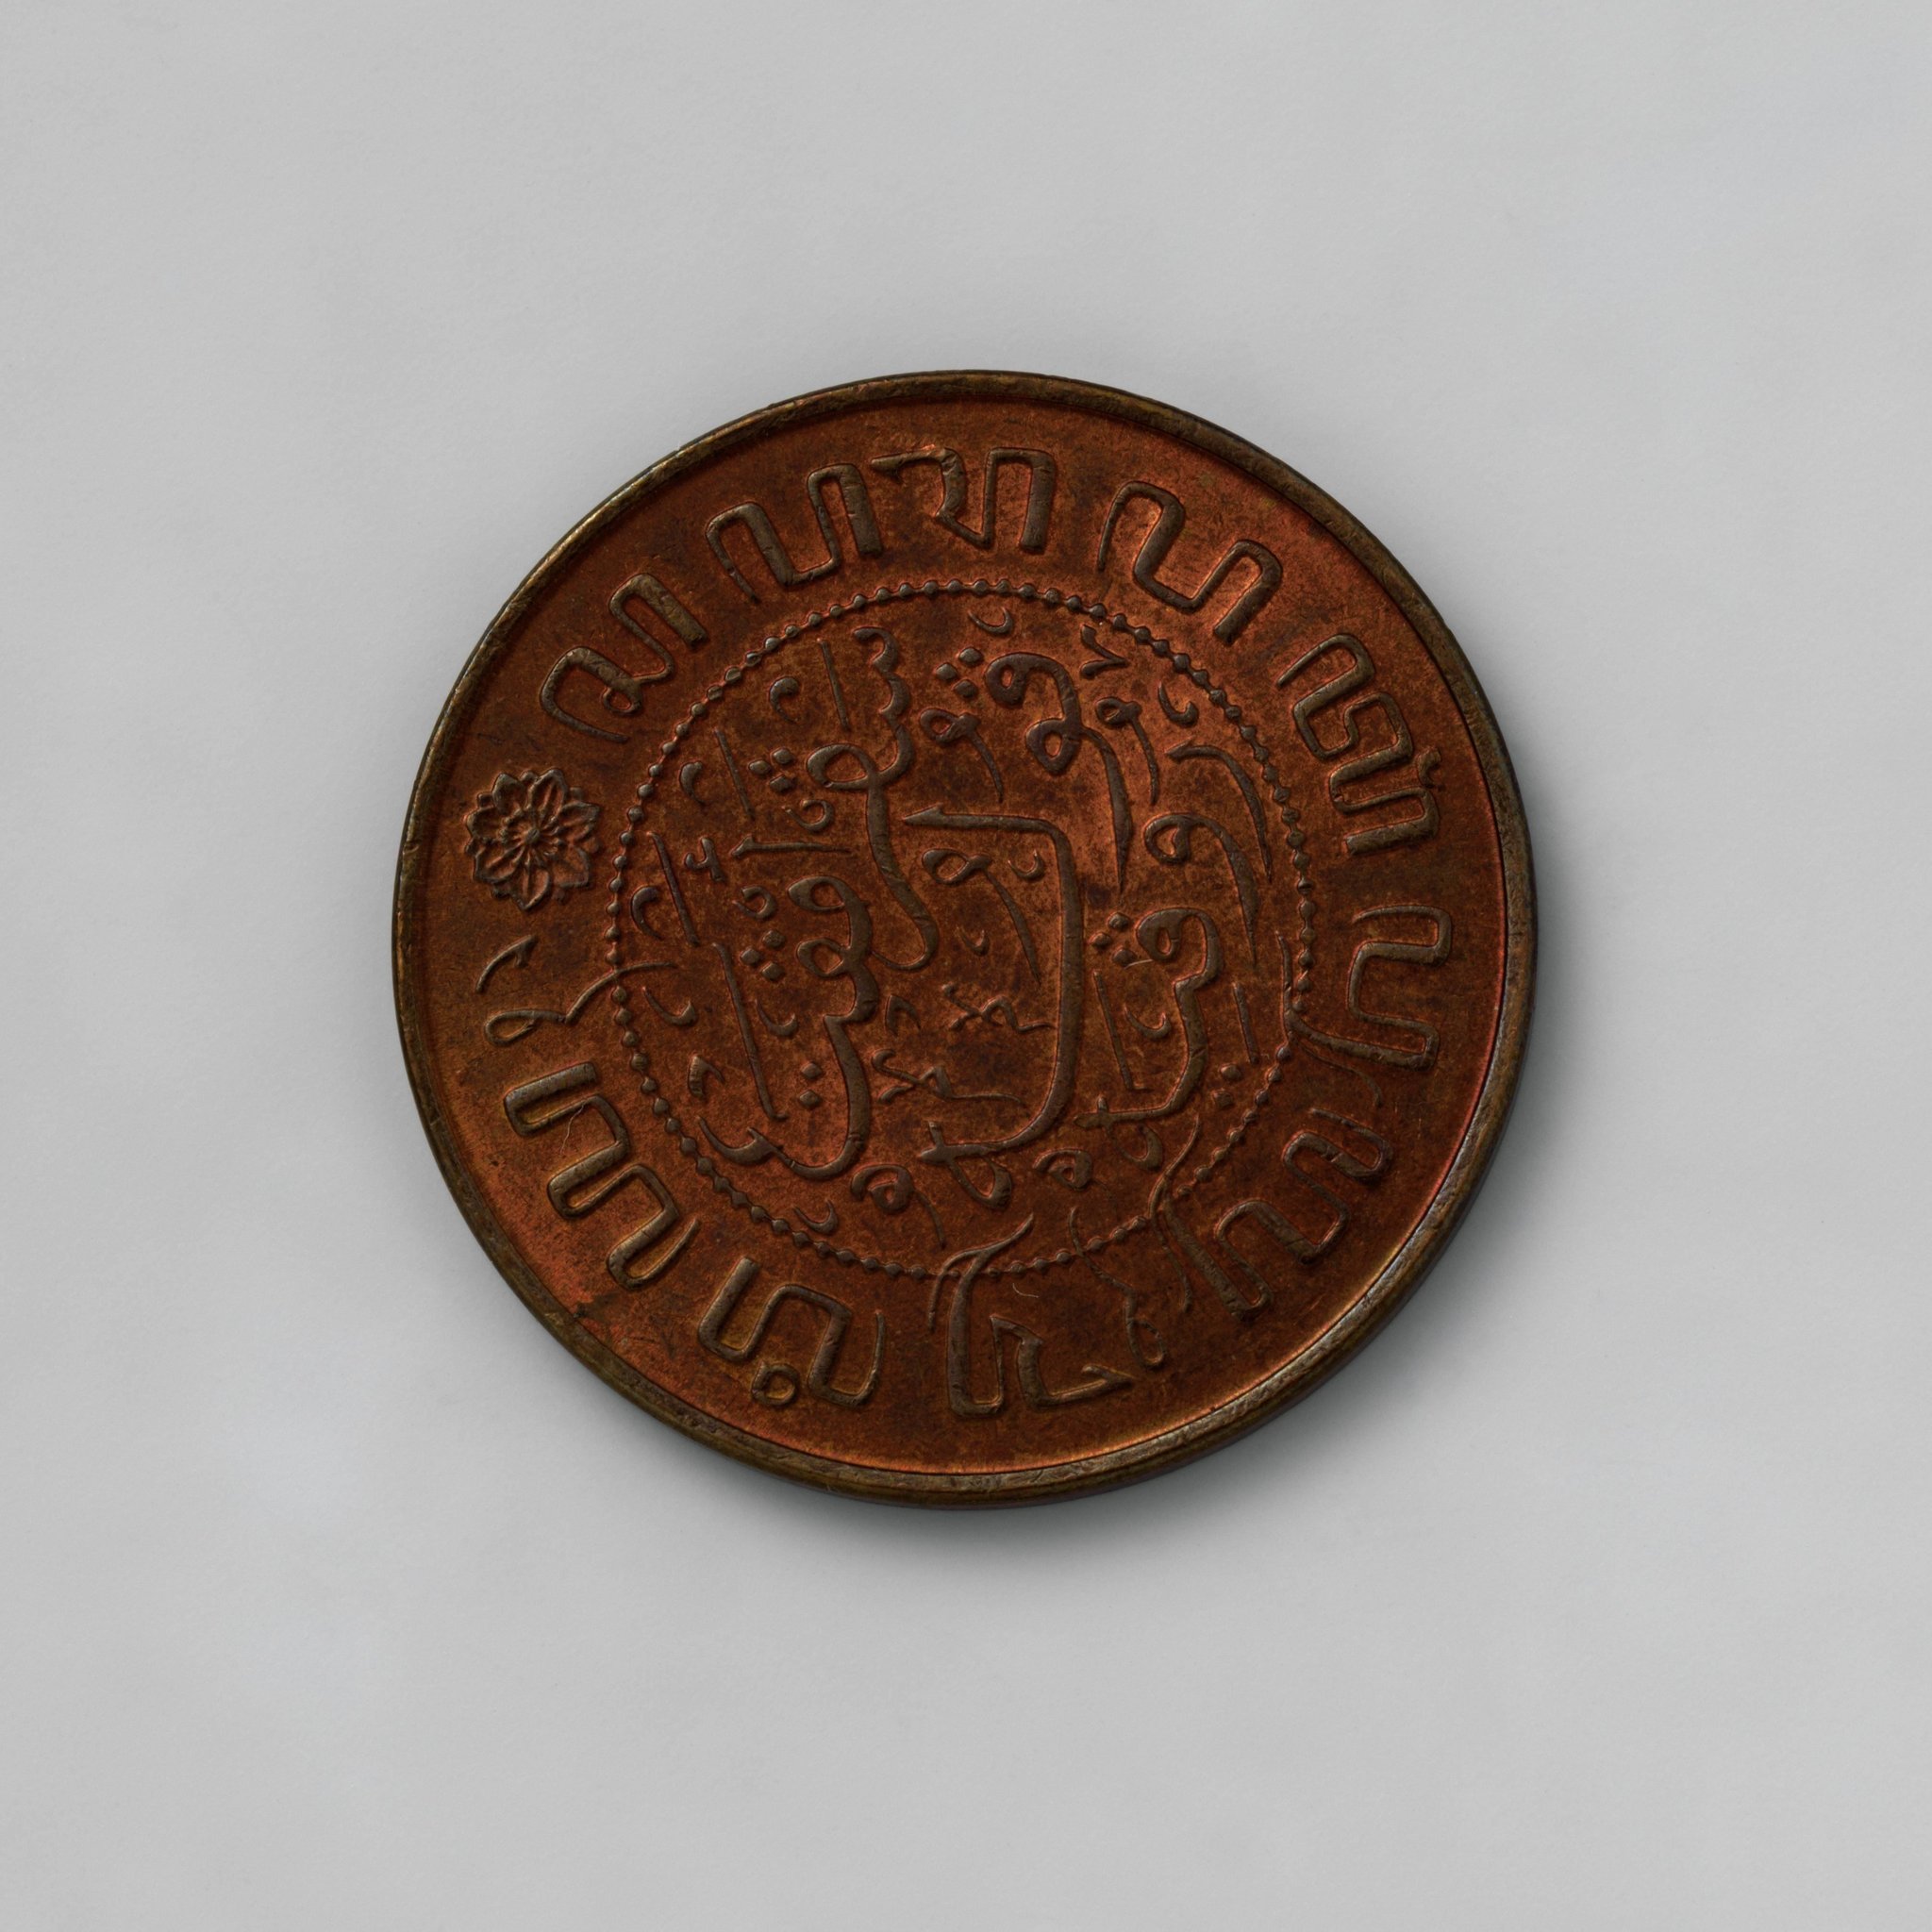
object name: coin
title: Nederlands Indië, 2½ cent, 1945 P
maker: wilhelmina of the netherlands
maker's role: print maker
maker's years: 1880-1962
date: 1945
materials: copper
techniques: striking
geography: philadelphia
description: Koperen munt. Voorzijde: tussen jaartal gekroond rijkswapenschild. Boven kroon landsaanduiding en onder wapenschild waarde-aanduiding. Keerzijde: driereregelig Maleis opschrift in Arabische letter- en orthografische tekens, waaromheen omschrift in het Javaans. Gladde rand.